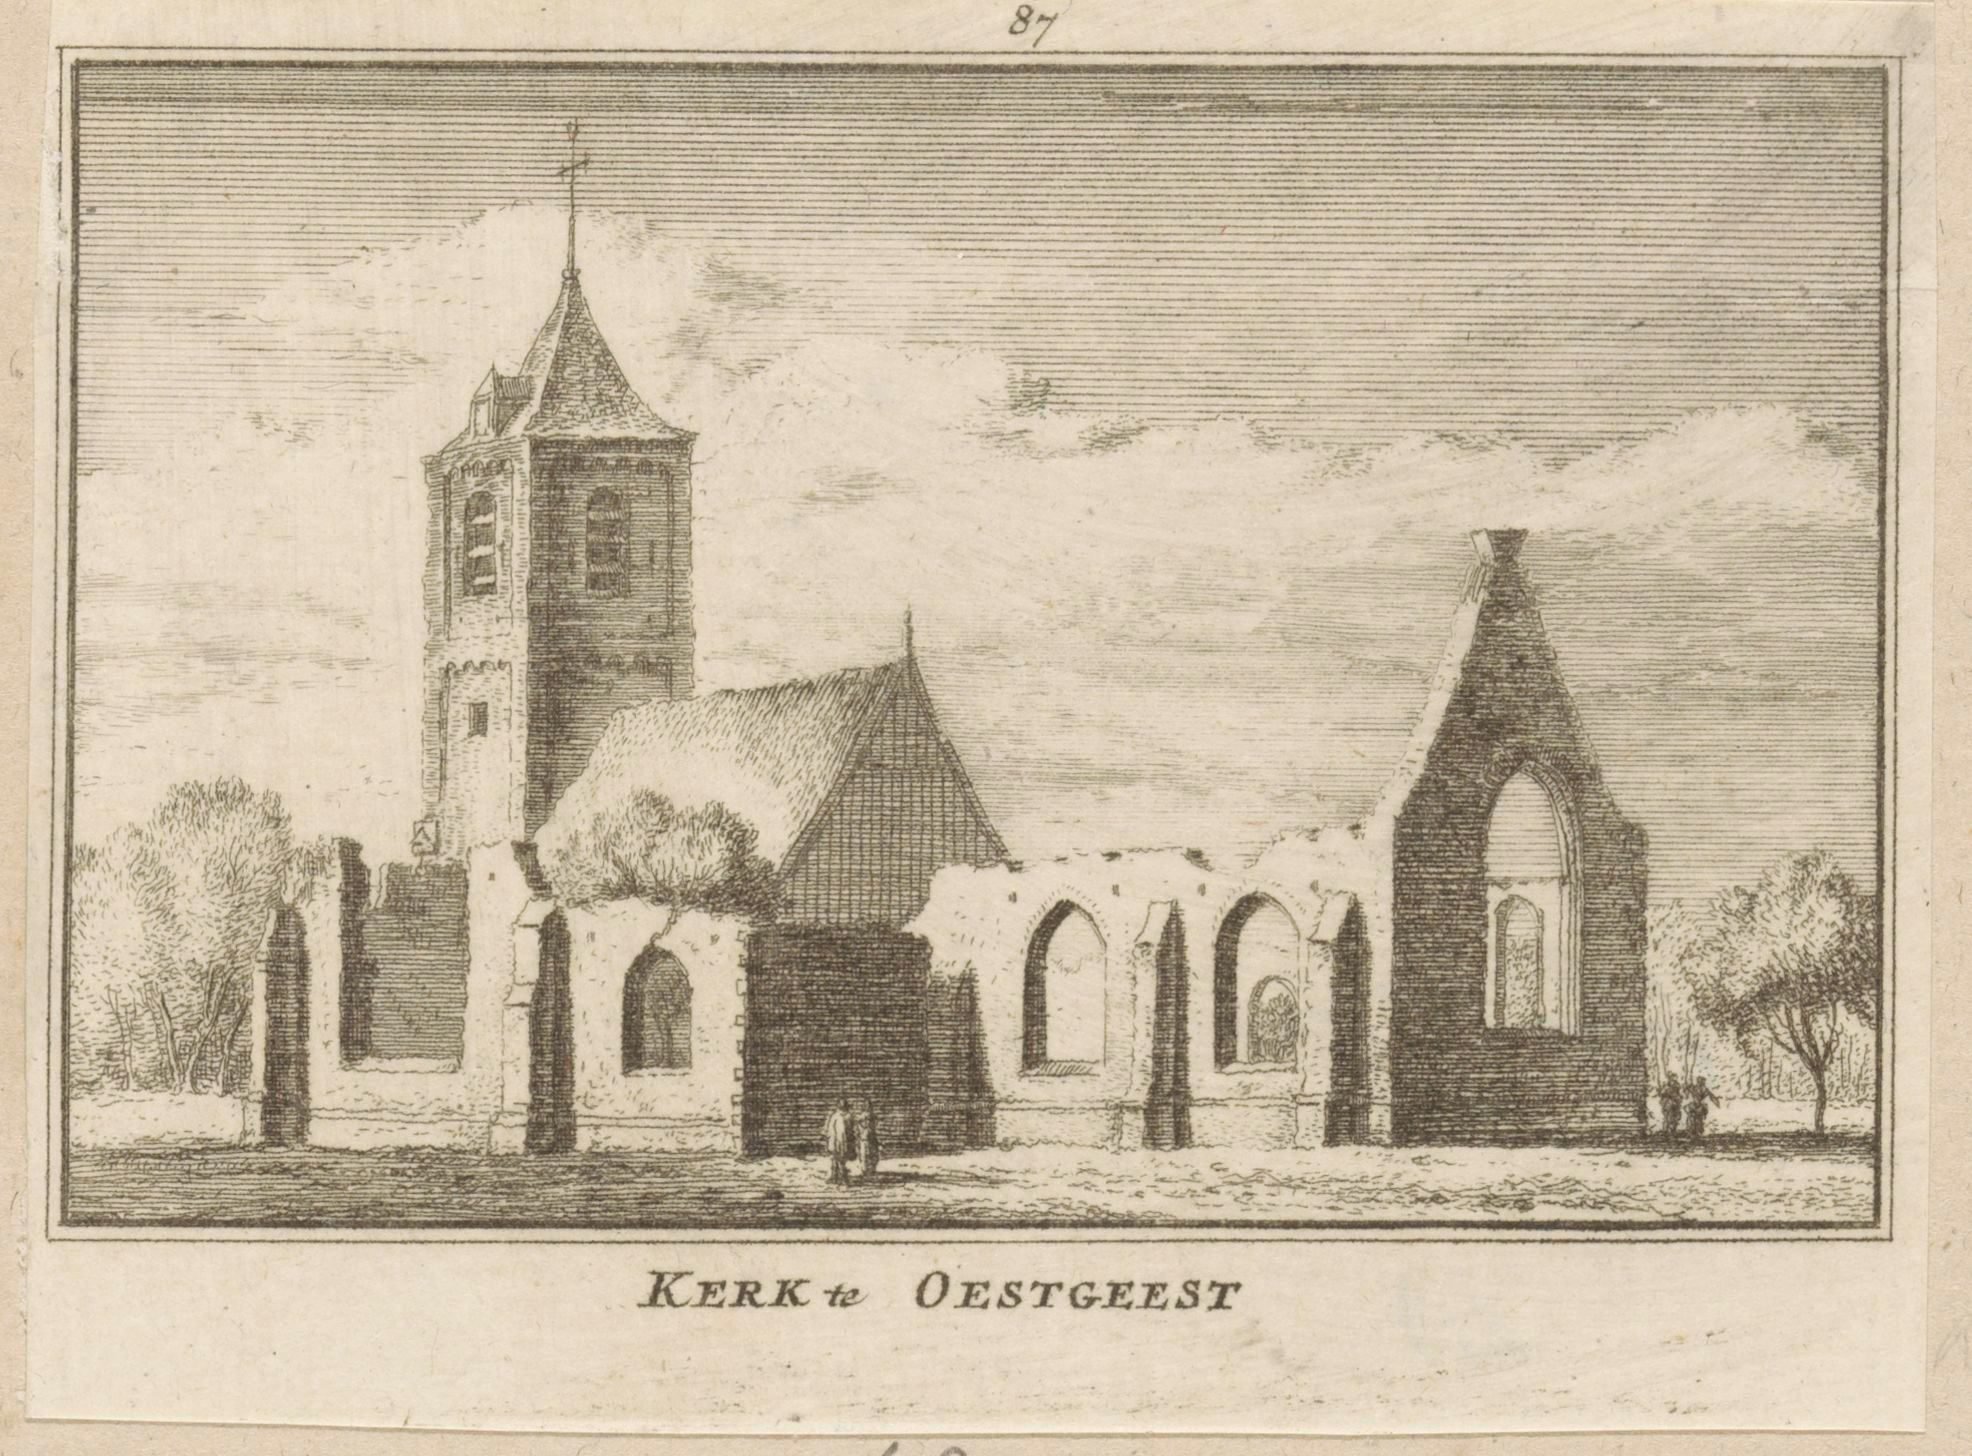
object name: book illustration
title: Gezicht op de ruïne van de kerk te Oegstgeest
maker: abraham rademaker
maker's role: draughtsman, print maker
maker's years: 1676-1735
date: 1725-1803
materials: paper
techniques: engraving, etching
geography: amsterdam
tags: ruin of church, monastery, etc.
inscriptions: collector's mark: Lugt 2228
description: Prent ook gebruikt in: Rademaker, Abraham. Kabinet van Nederlandsche outheden en gezichten: vervat in 300 konstplaaten (…). 2 delen. Amsterdam: Willem Barents, 1725, dl. 1, ill. 87. Na 1725 is deze prent nog in verschillende heruitgaven verschenen, uitgegeven in 1727-1733, 1770-1771 en 1792-1803. Uit welke uitgave het huidige exemplaar precies komt is niet na te gaan.